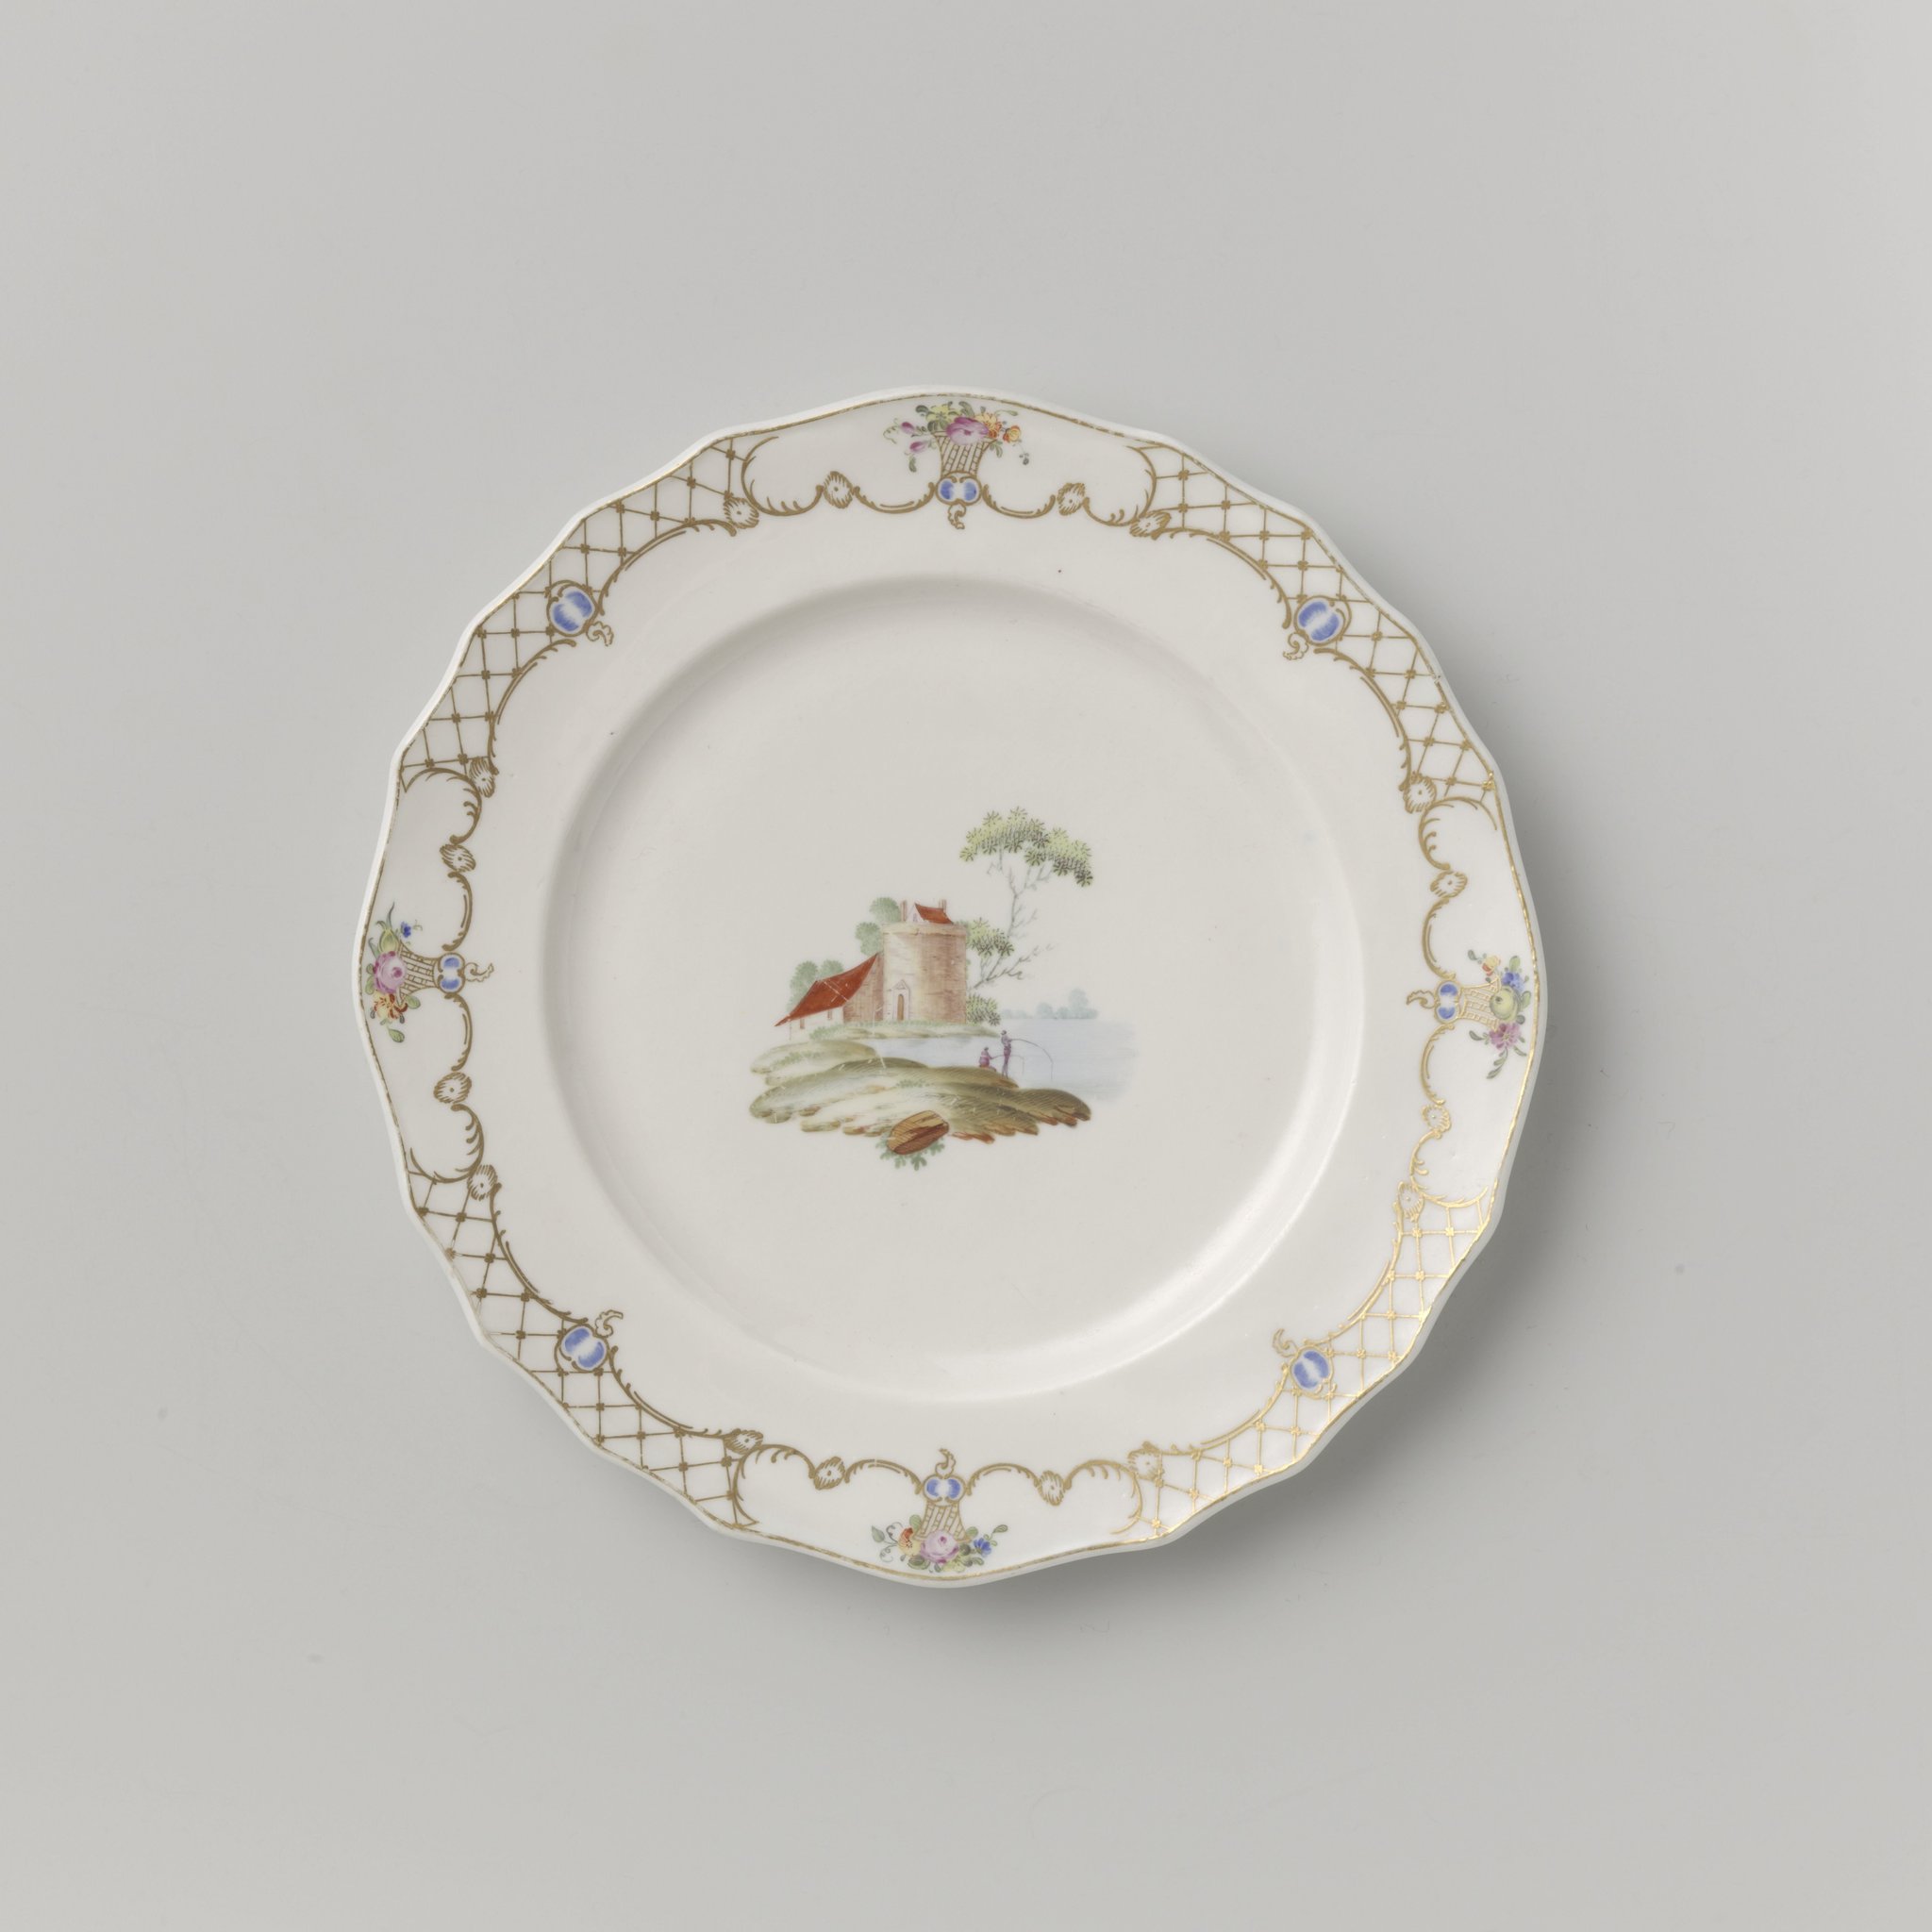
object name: plate dish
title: Bord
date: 1777-1790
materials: porcelain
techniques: painted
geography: doornik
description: Two plates. Soft-paste porcelain. Tournai, decorated in The Hague, c. 1777 - 1790. Factory of Anton Lyncker or his heirs.